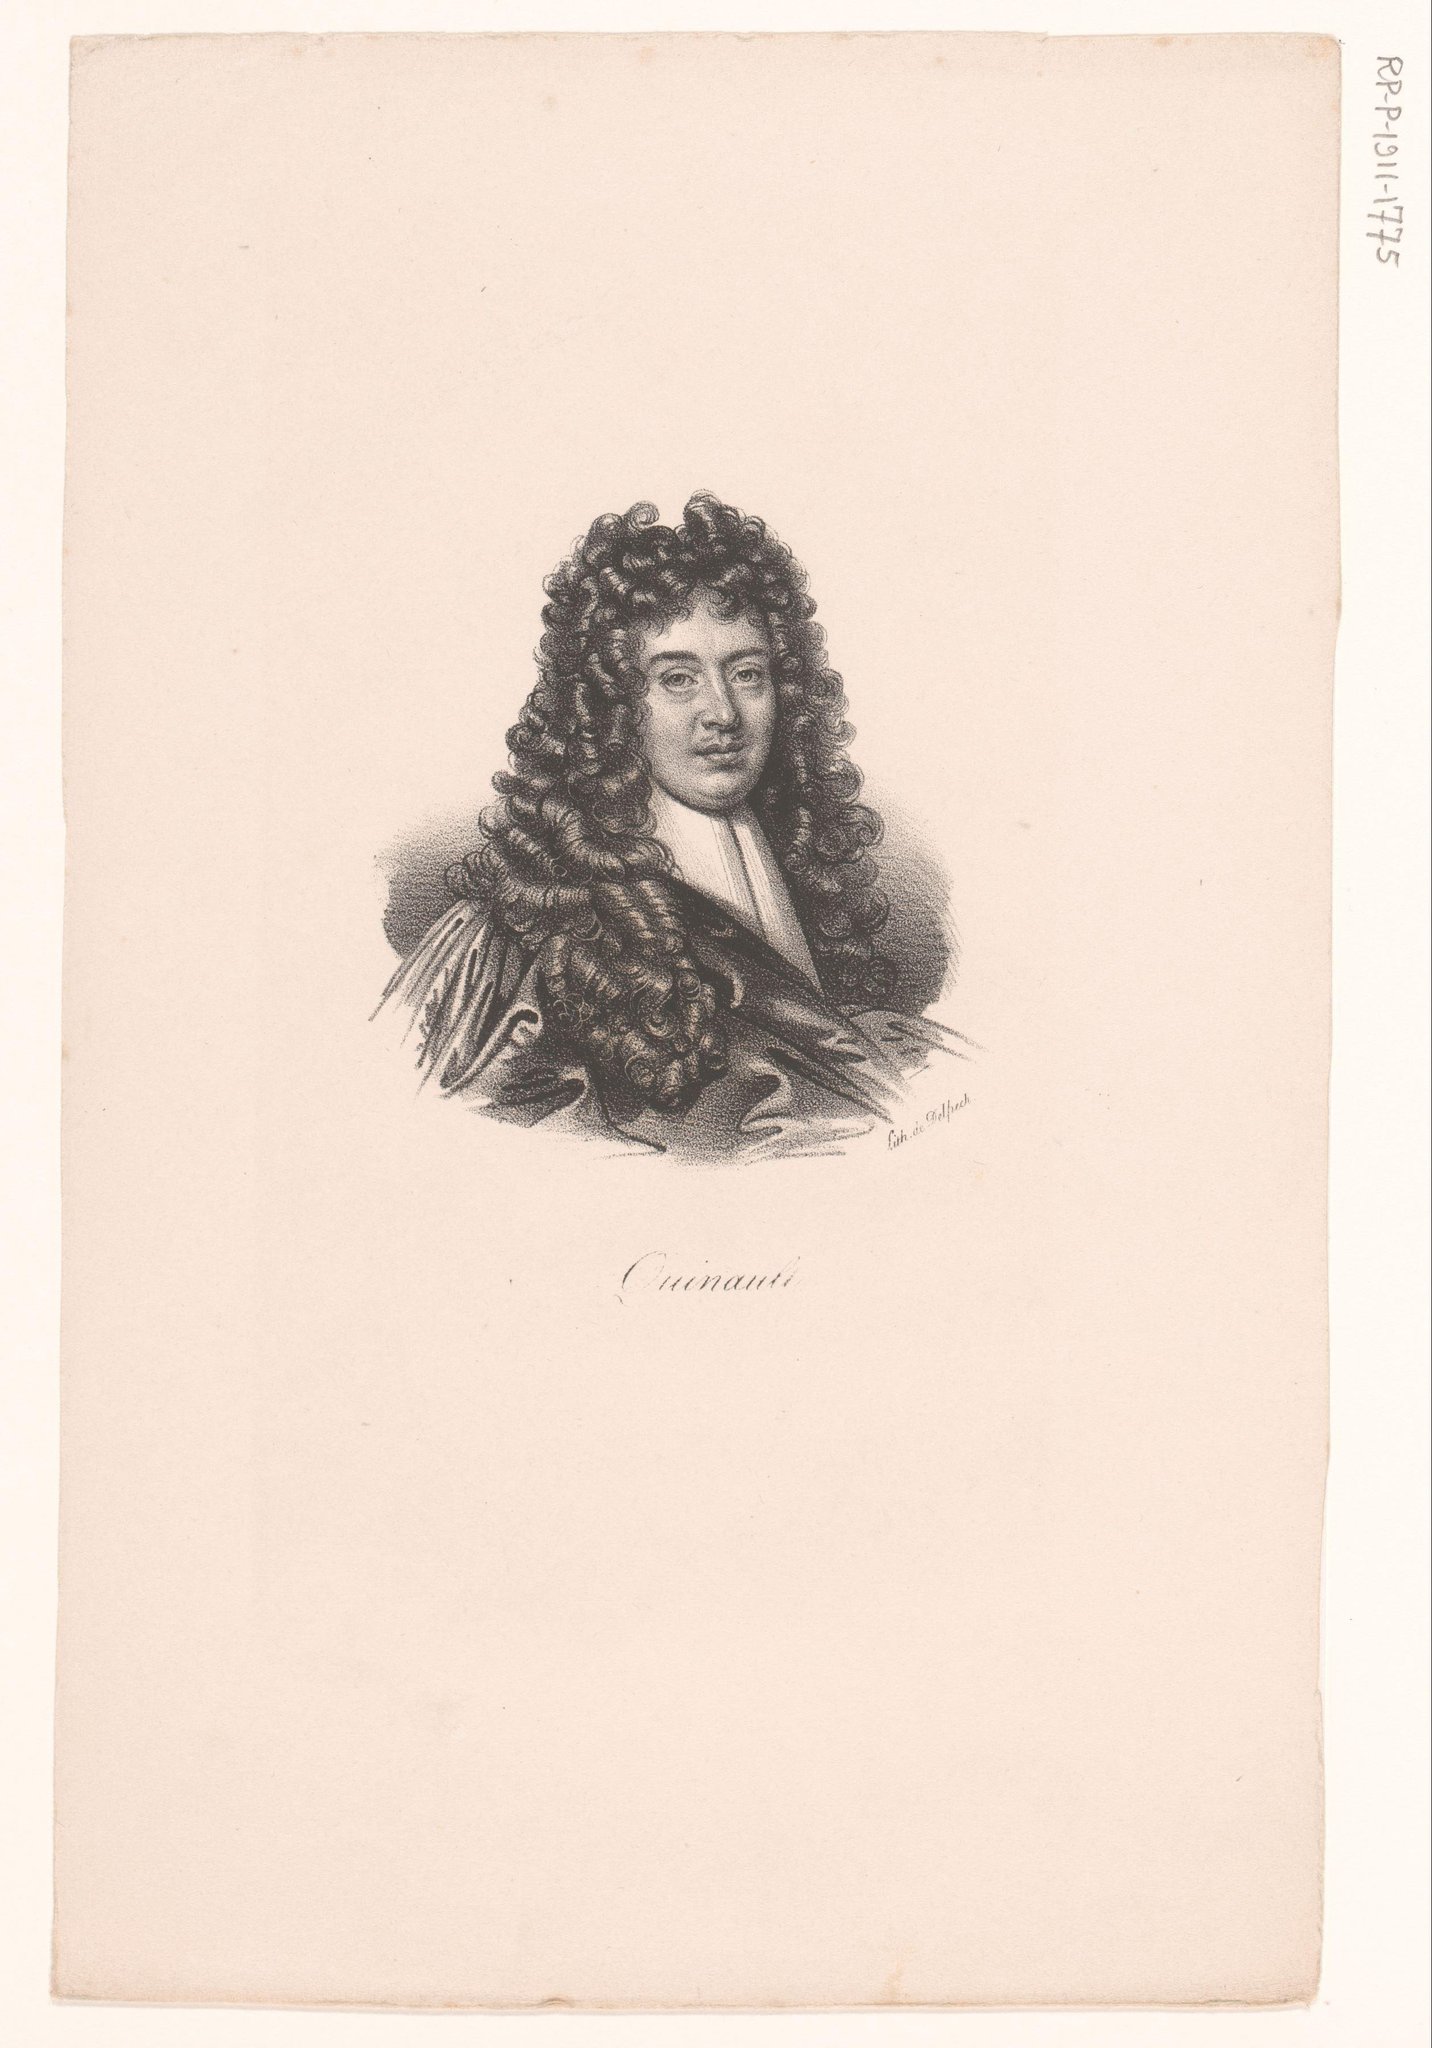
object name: print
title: Portret van Philippe Quinault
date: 1818-1842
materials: paper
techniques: lithograph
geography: paris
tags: historical persons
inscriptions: collector's mark: Lugt 2228a